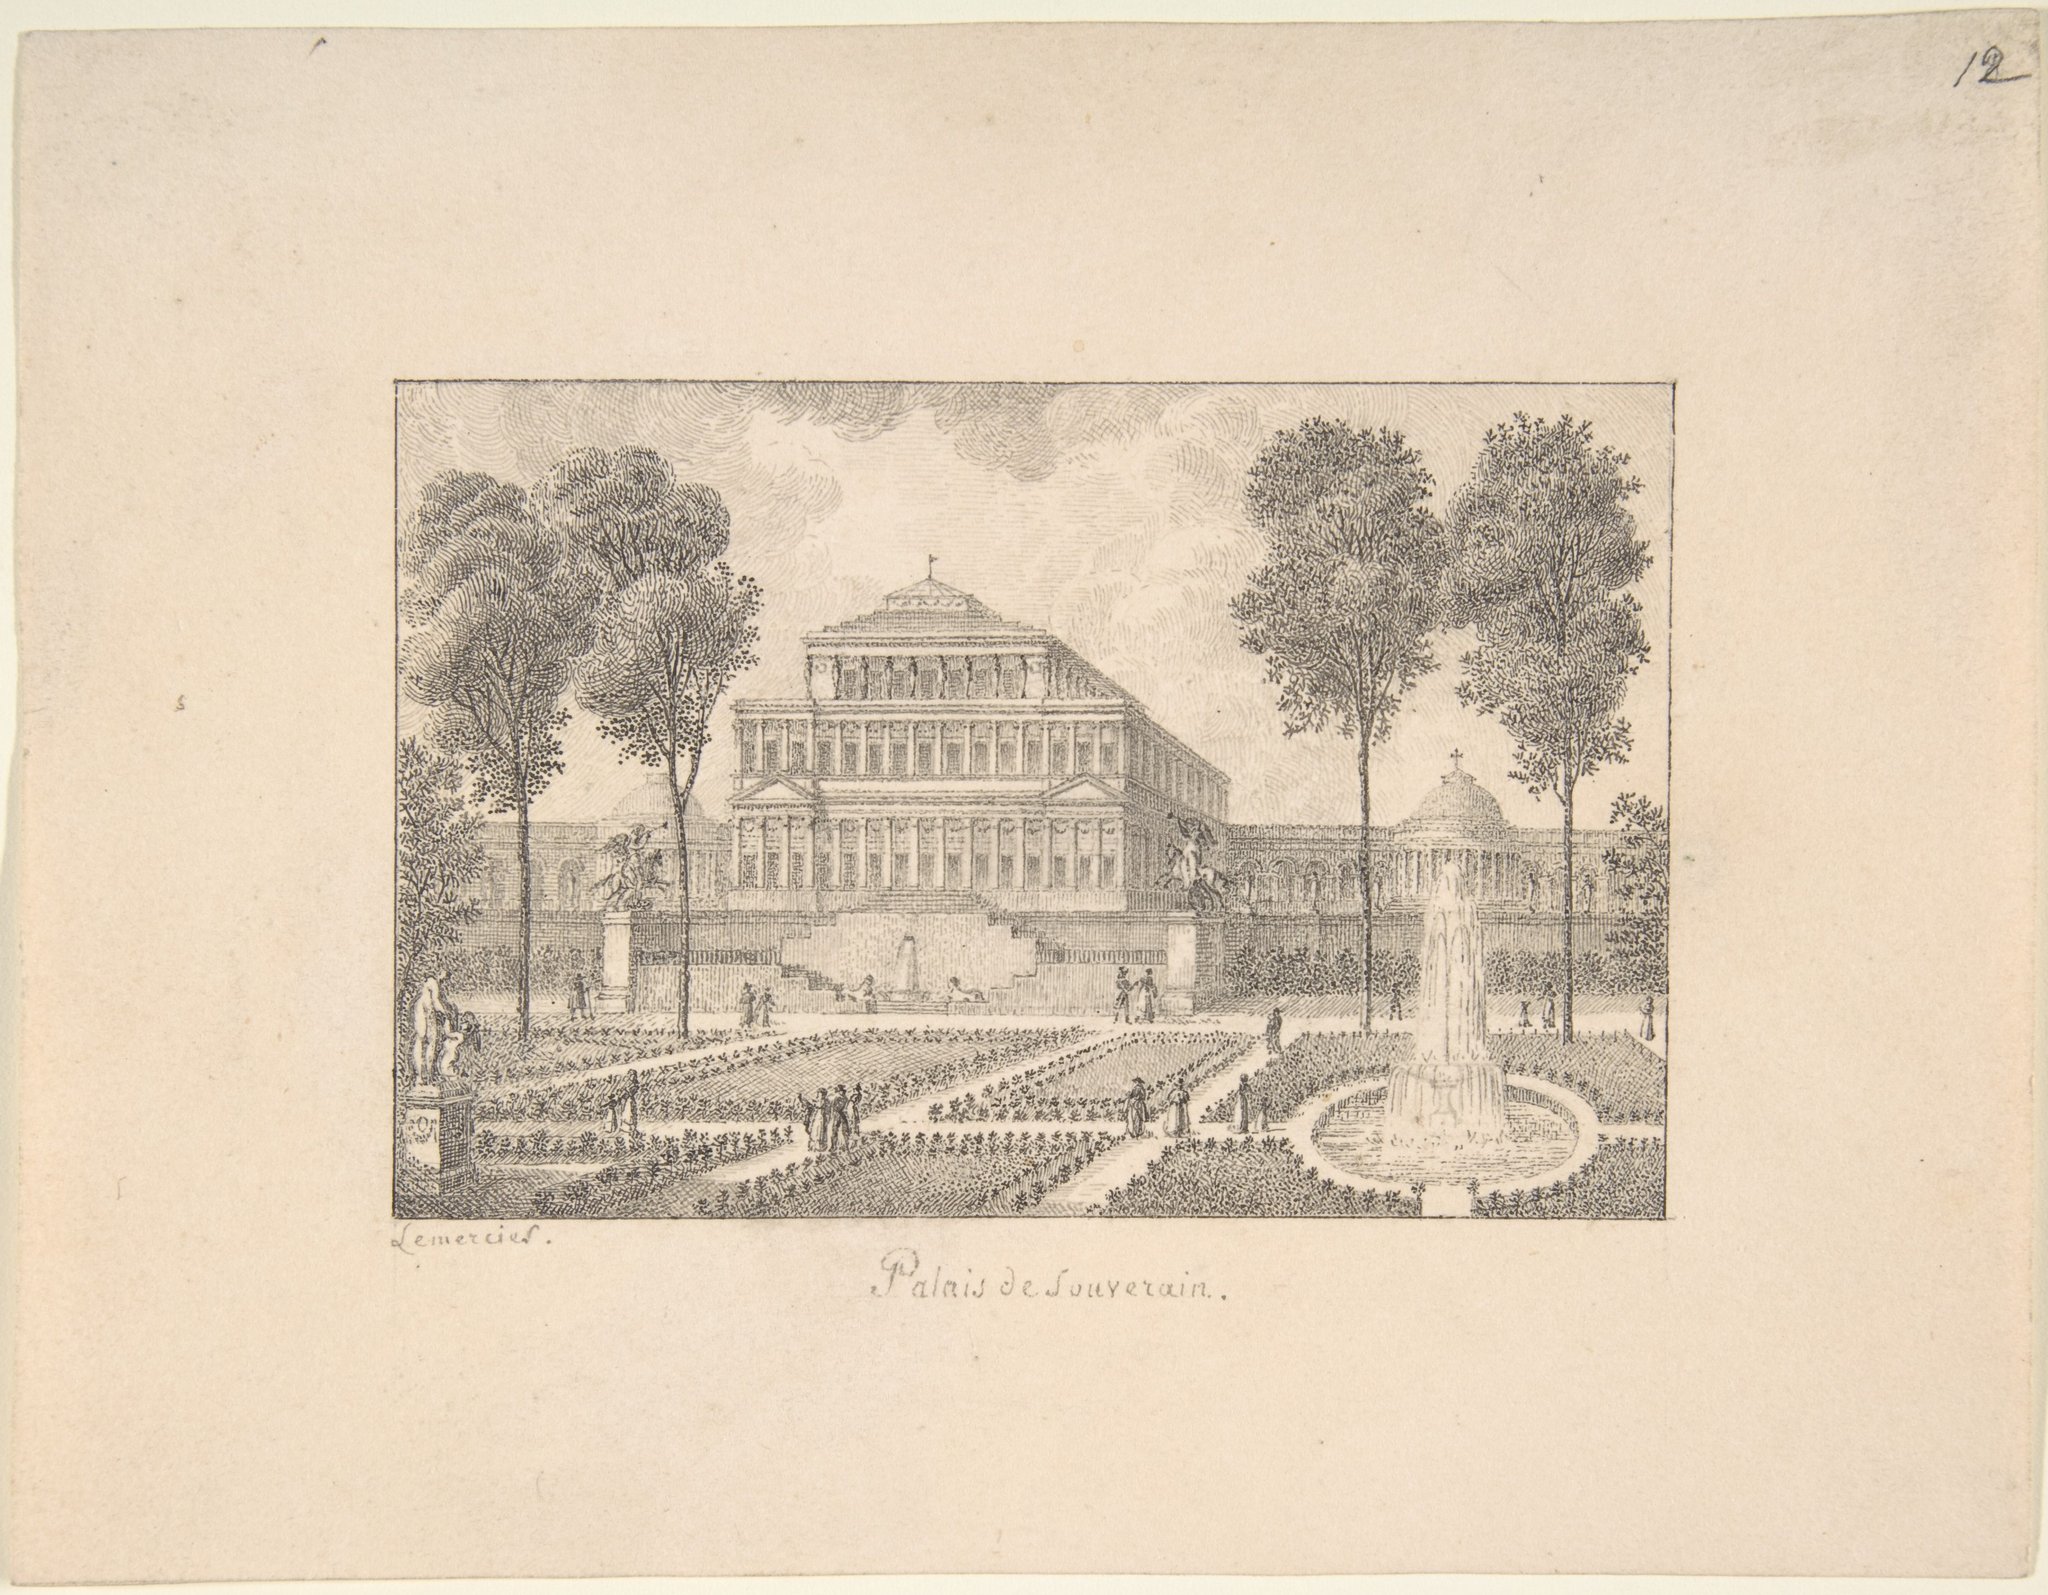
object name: drawing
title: A Ruler's Palace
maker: joseph lemercier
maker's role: artist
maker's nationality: french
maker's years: 1803-1887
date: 1801-1900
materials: ink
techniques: pen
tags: fountains,palaces